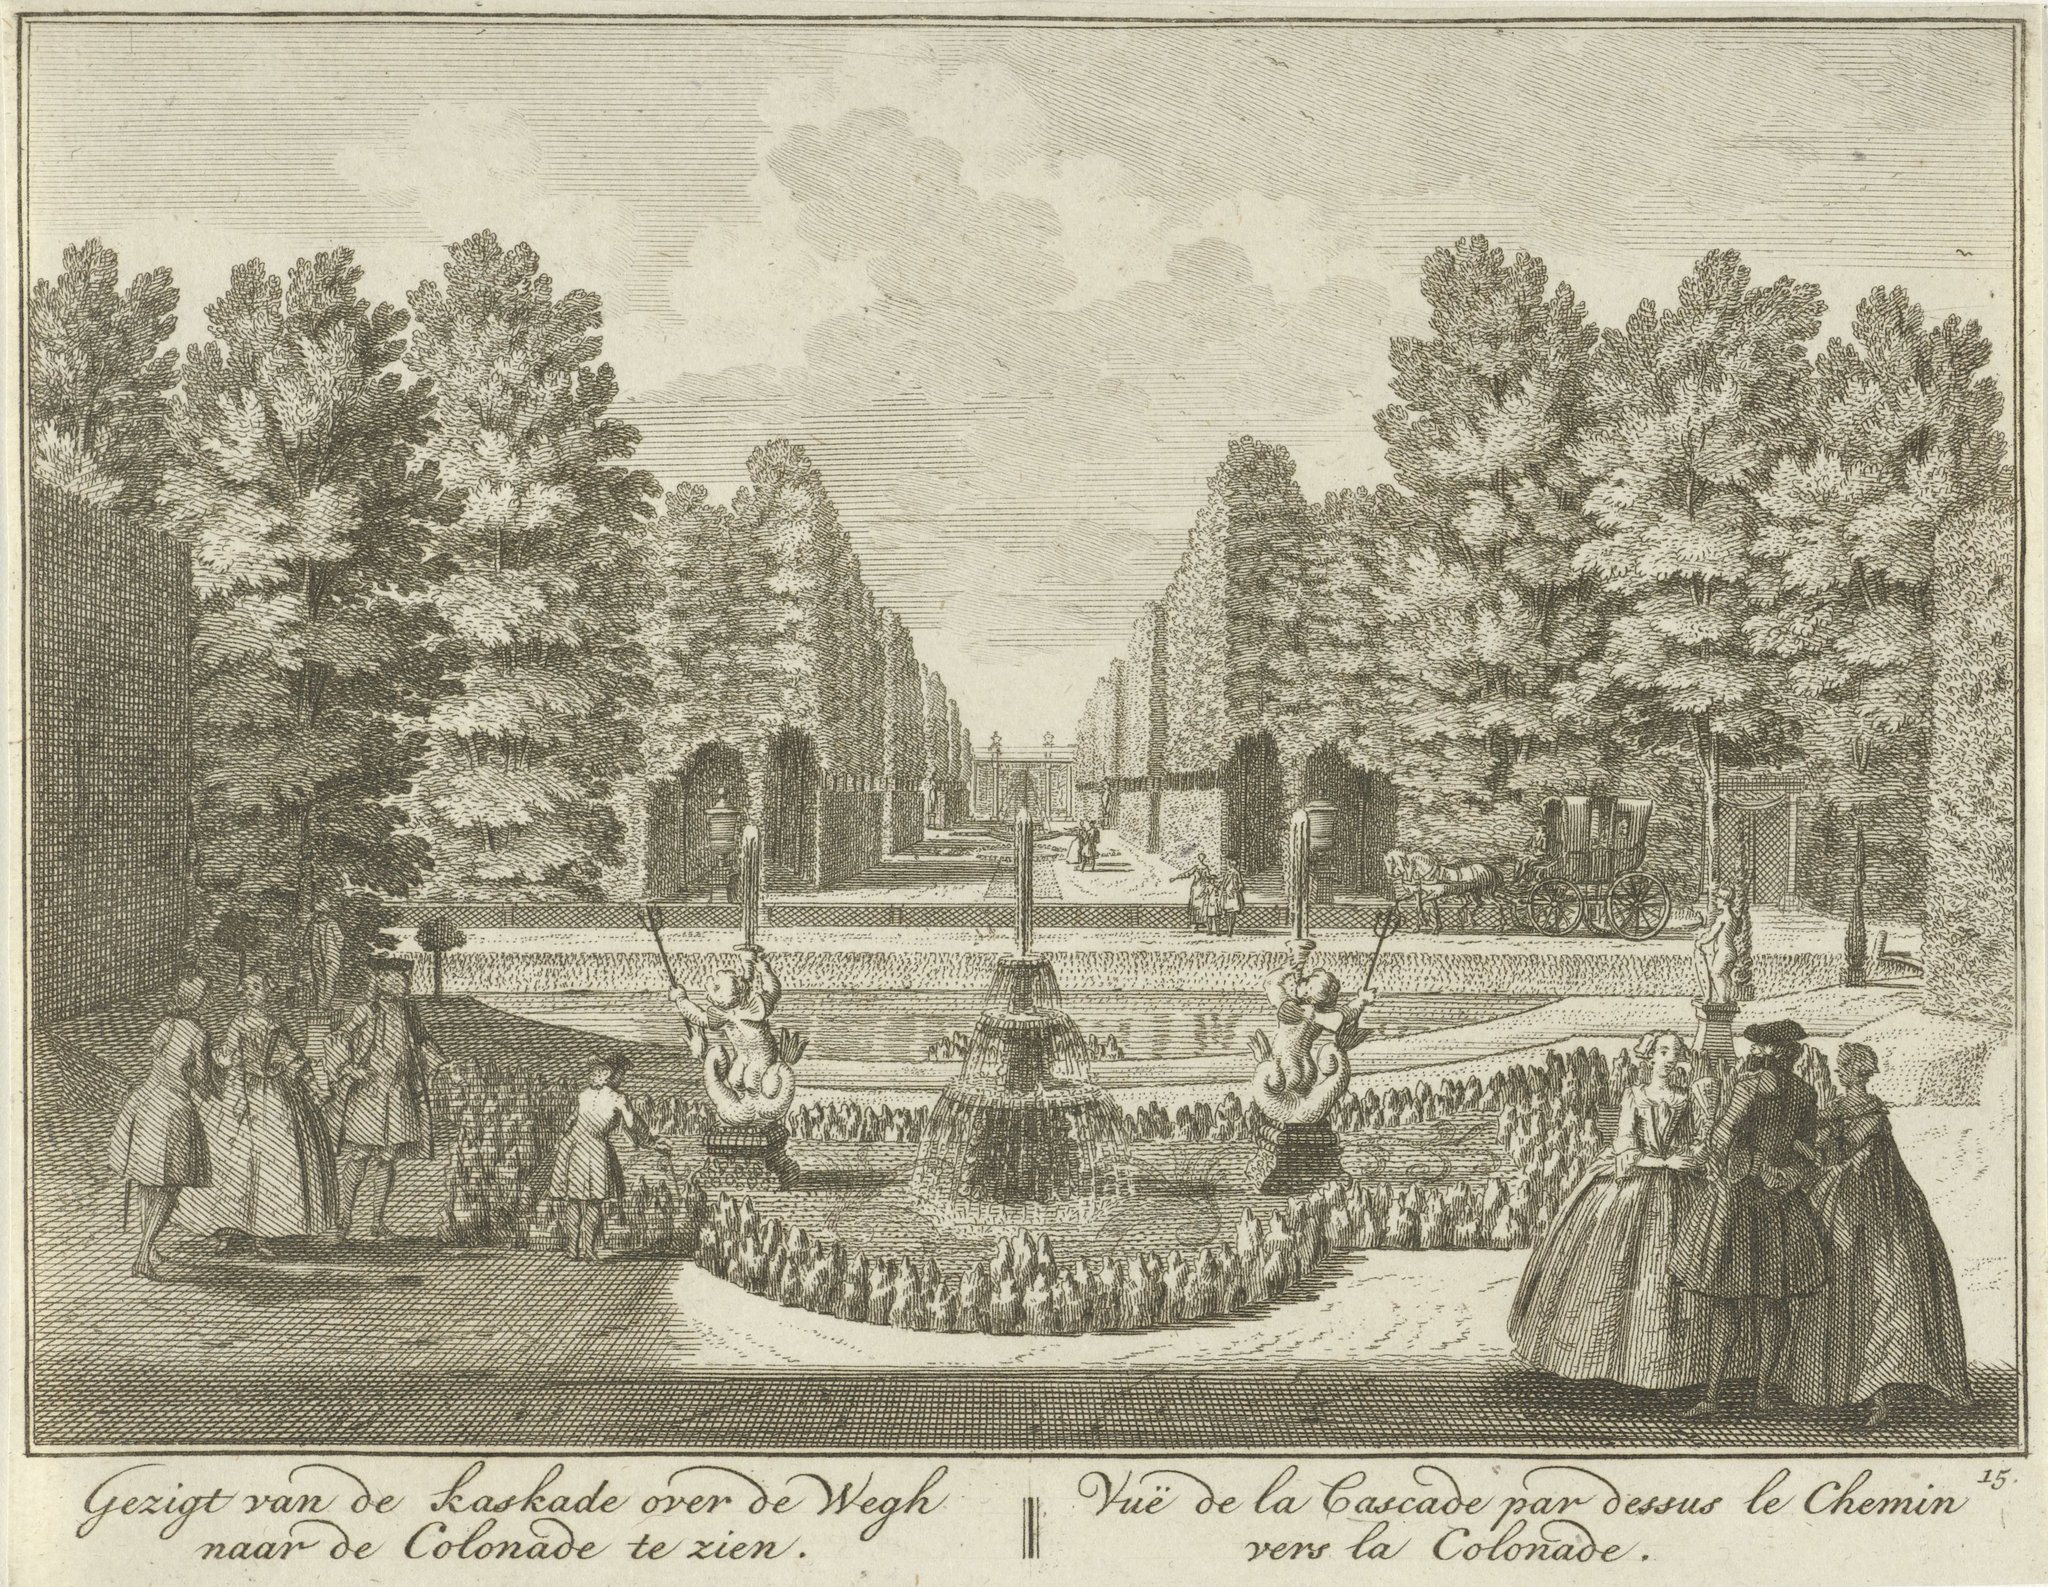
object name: print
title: Gezicht op de vijver richting de colonnade in de tuin van Huis ter Meer te Maarssen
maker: hendrik de leth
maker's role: draughtsman, print maker, publisher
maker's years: 1703-1766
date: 1740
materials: paper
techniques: etching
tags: garden fountain, french or architectonic garden; formal garden, country-house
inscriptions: collector's mark: Lugt 2228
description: Gezicht op de vijver richting de colonnade in de Franse tuin van Huis ter Meer. Op de voorgrond staan twee groepjes converserende figuren. De prent maakt deel uit van een serie met 26 gezichten op Huis ter Meer en het bijbehorende landgoed te Maarssen.